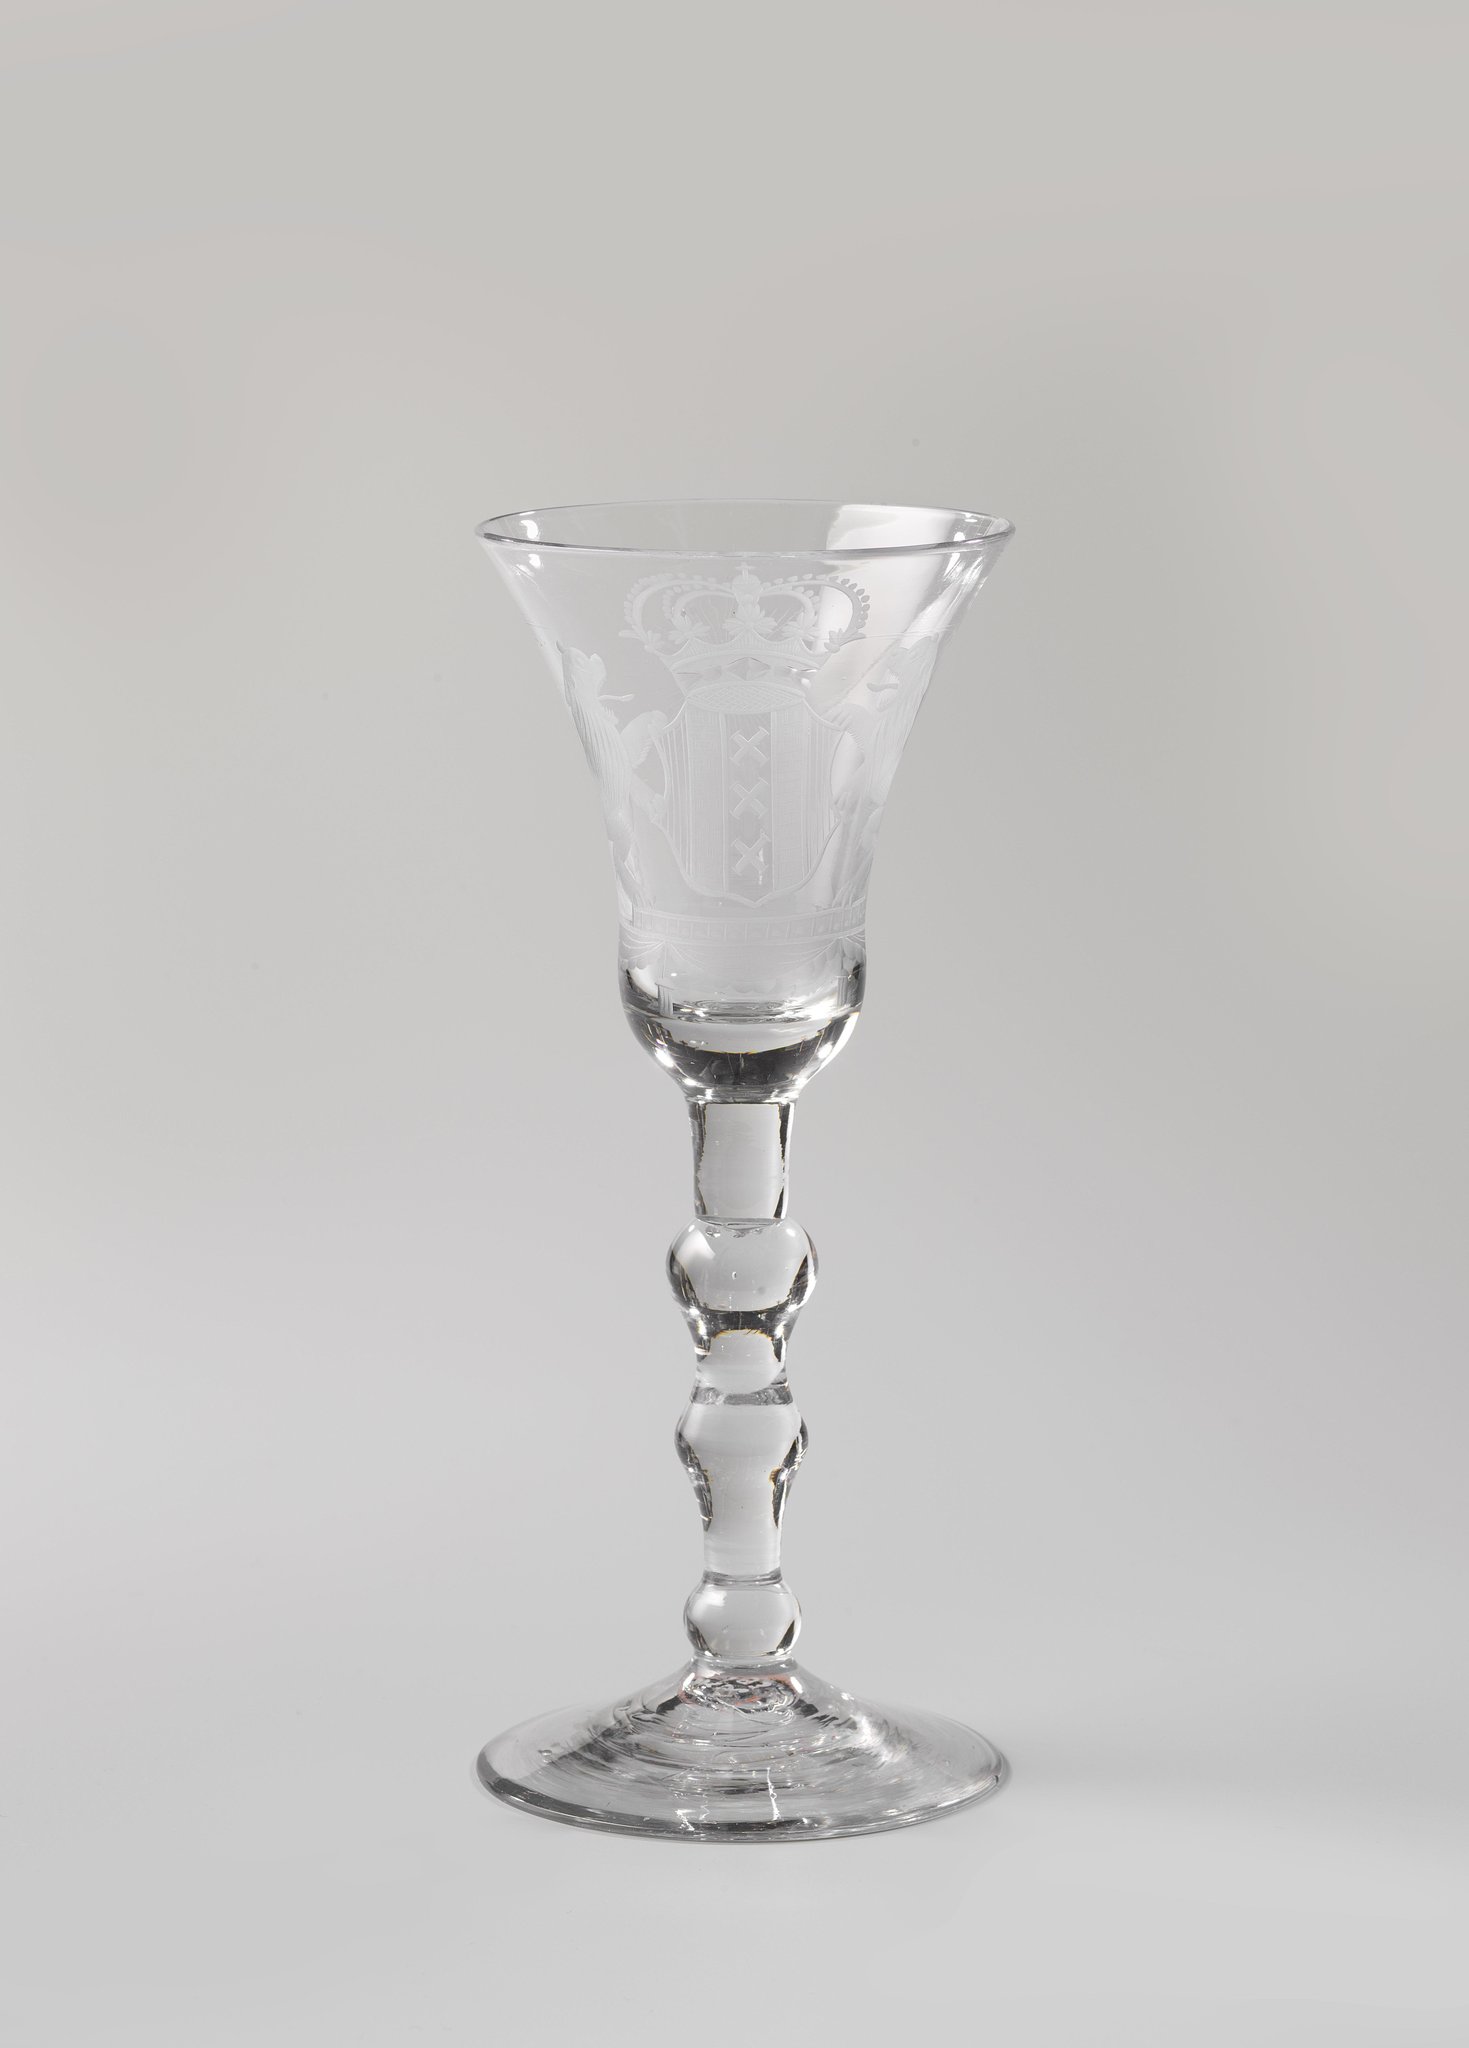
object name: goblet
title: Bokaal met het wapen van de stad Amsterdam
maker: Anonymous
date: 1725-1750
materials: glass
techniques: glassblowing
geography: northern netherlands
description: Bokaal met conische voet. Balustervormige stam met drie knopen. Op de klokvormige kelk het gekroonde wapen van de stad Amsterdam, geflankeerd door twee leeuwen. Op de keerzijde een stralende zon.